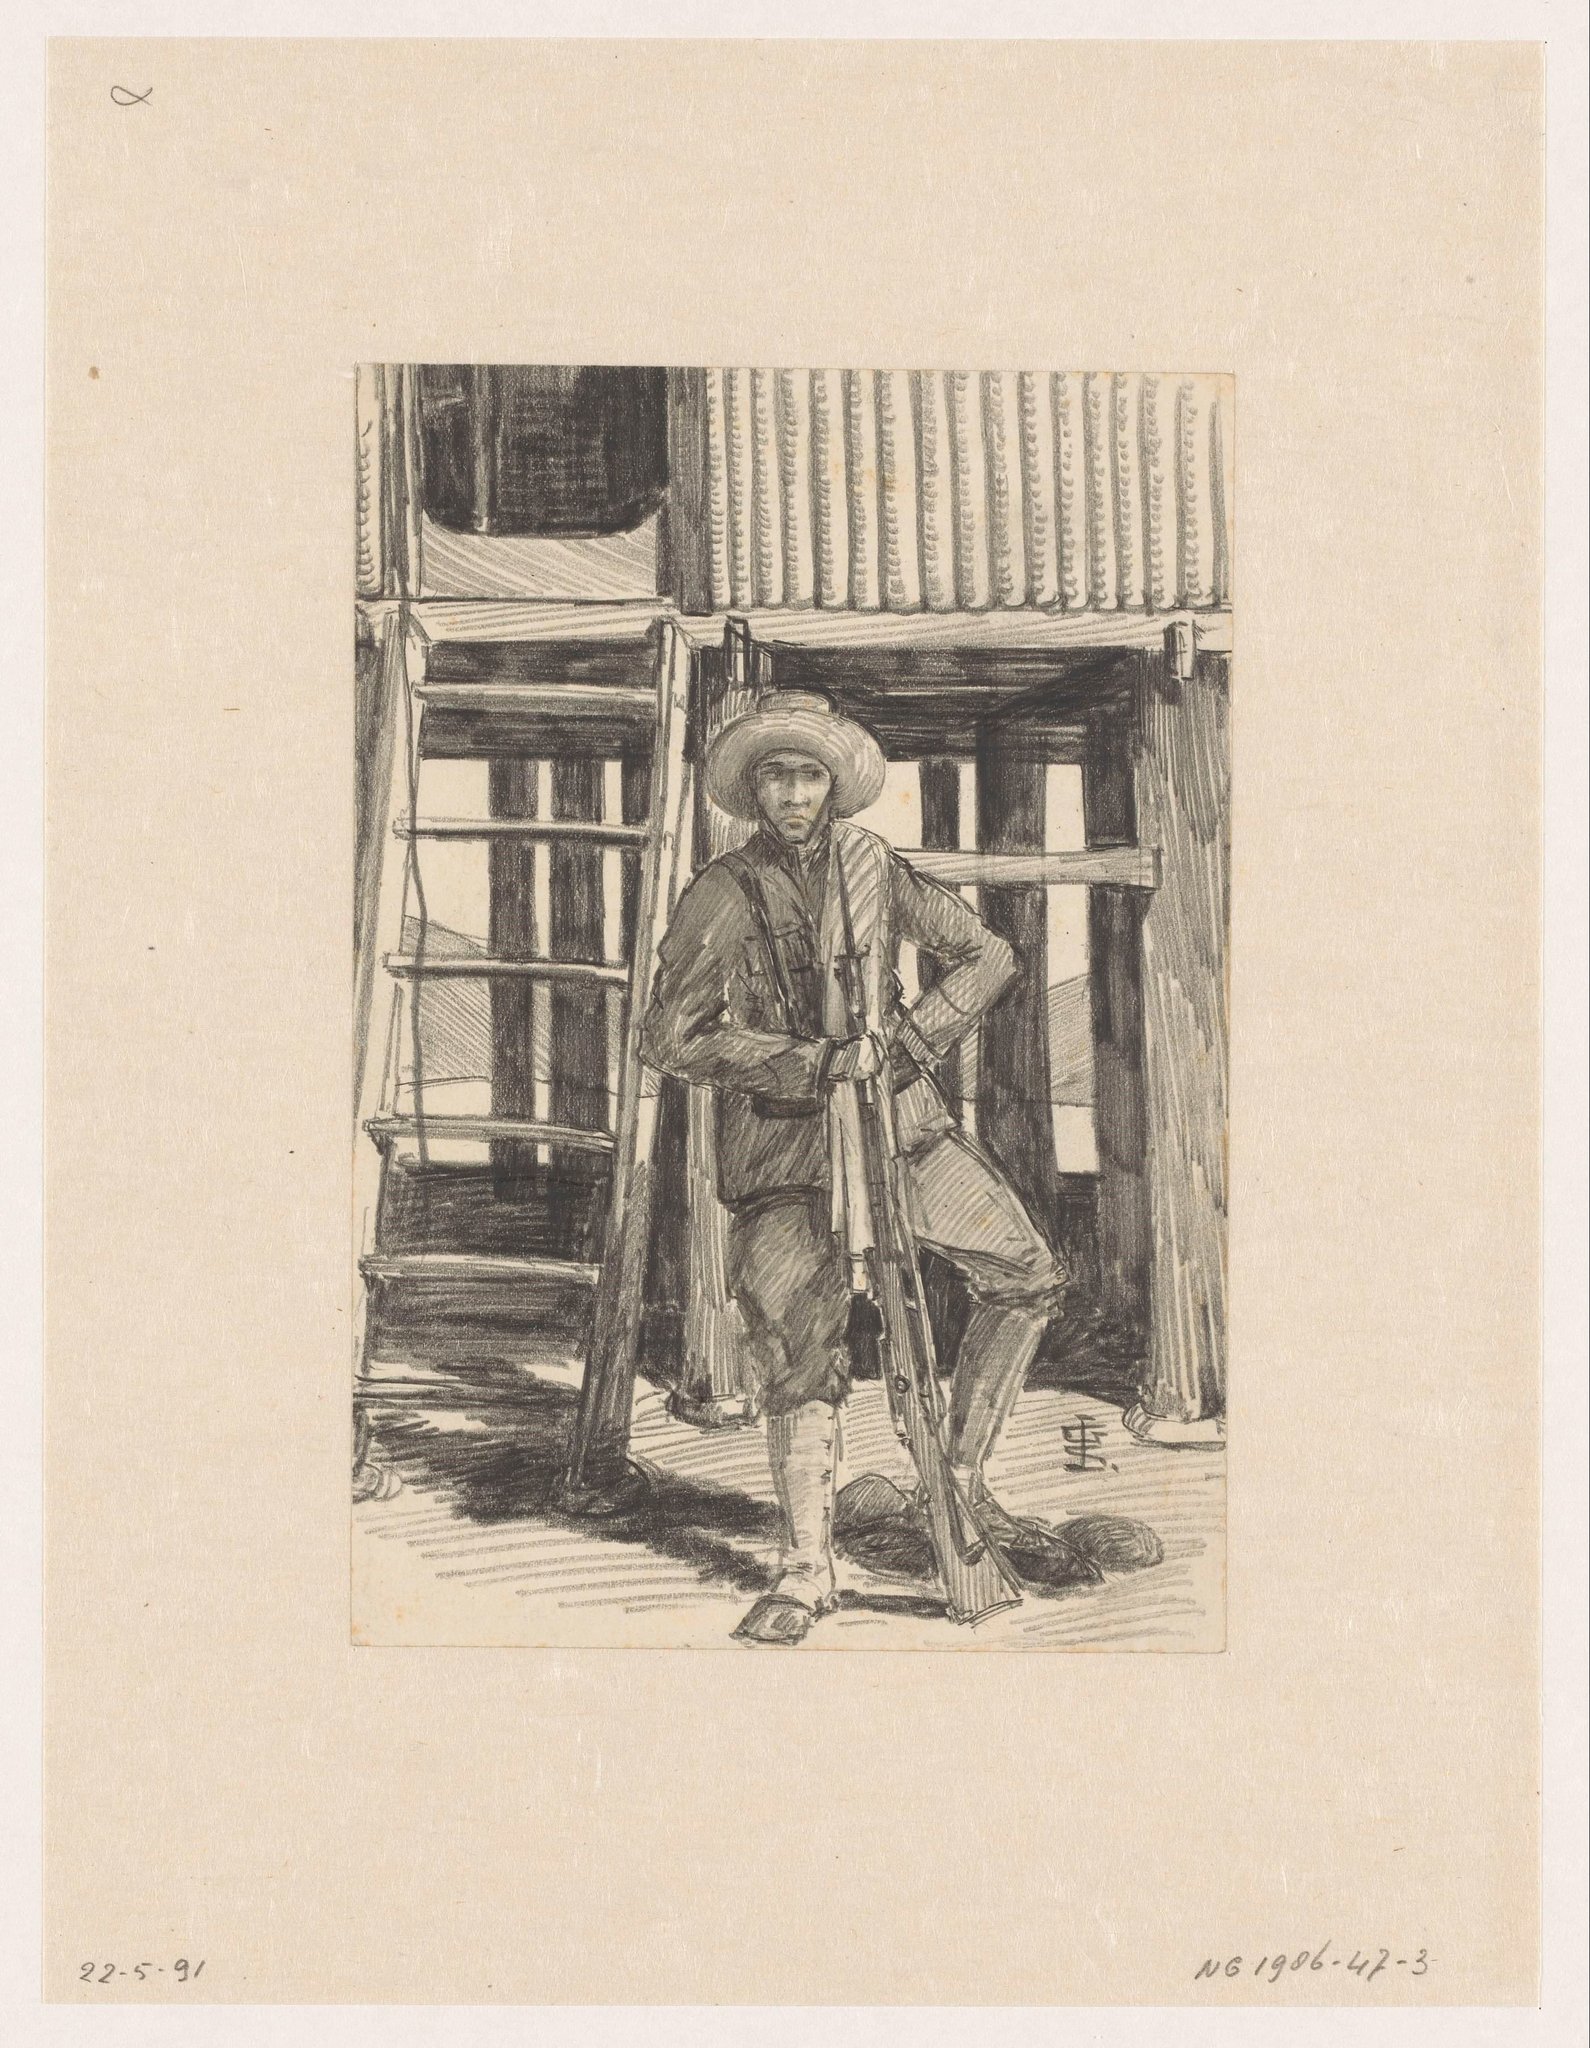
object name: drawing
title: Soldaat met geweer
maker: johan gerard sinia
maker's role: draughtsman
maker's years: 1875-1948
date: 1900-1910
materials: chalk, paper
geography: south celebes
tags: hoorn (north holland), johan gerard sinia, the soldier; the soldier's life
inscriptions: signature: ‘JGS’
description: J. G. Sinia was KNIL-officier, auteur en kunstenaar. Hij bezocht de buitenposten van Nederlands-Indië in de eerste jaren van de 20e eeuw. In april 1908 wordt Sinia overgeplaatst naar Zuidwest-Celebes. Hij wordt hier als militair en civiel gezaghebber aangesteld in het bebied Soppeng. Op 12 oktober 1909 keert hij terug naar Nederland.